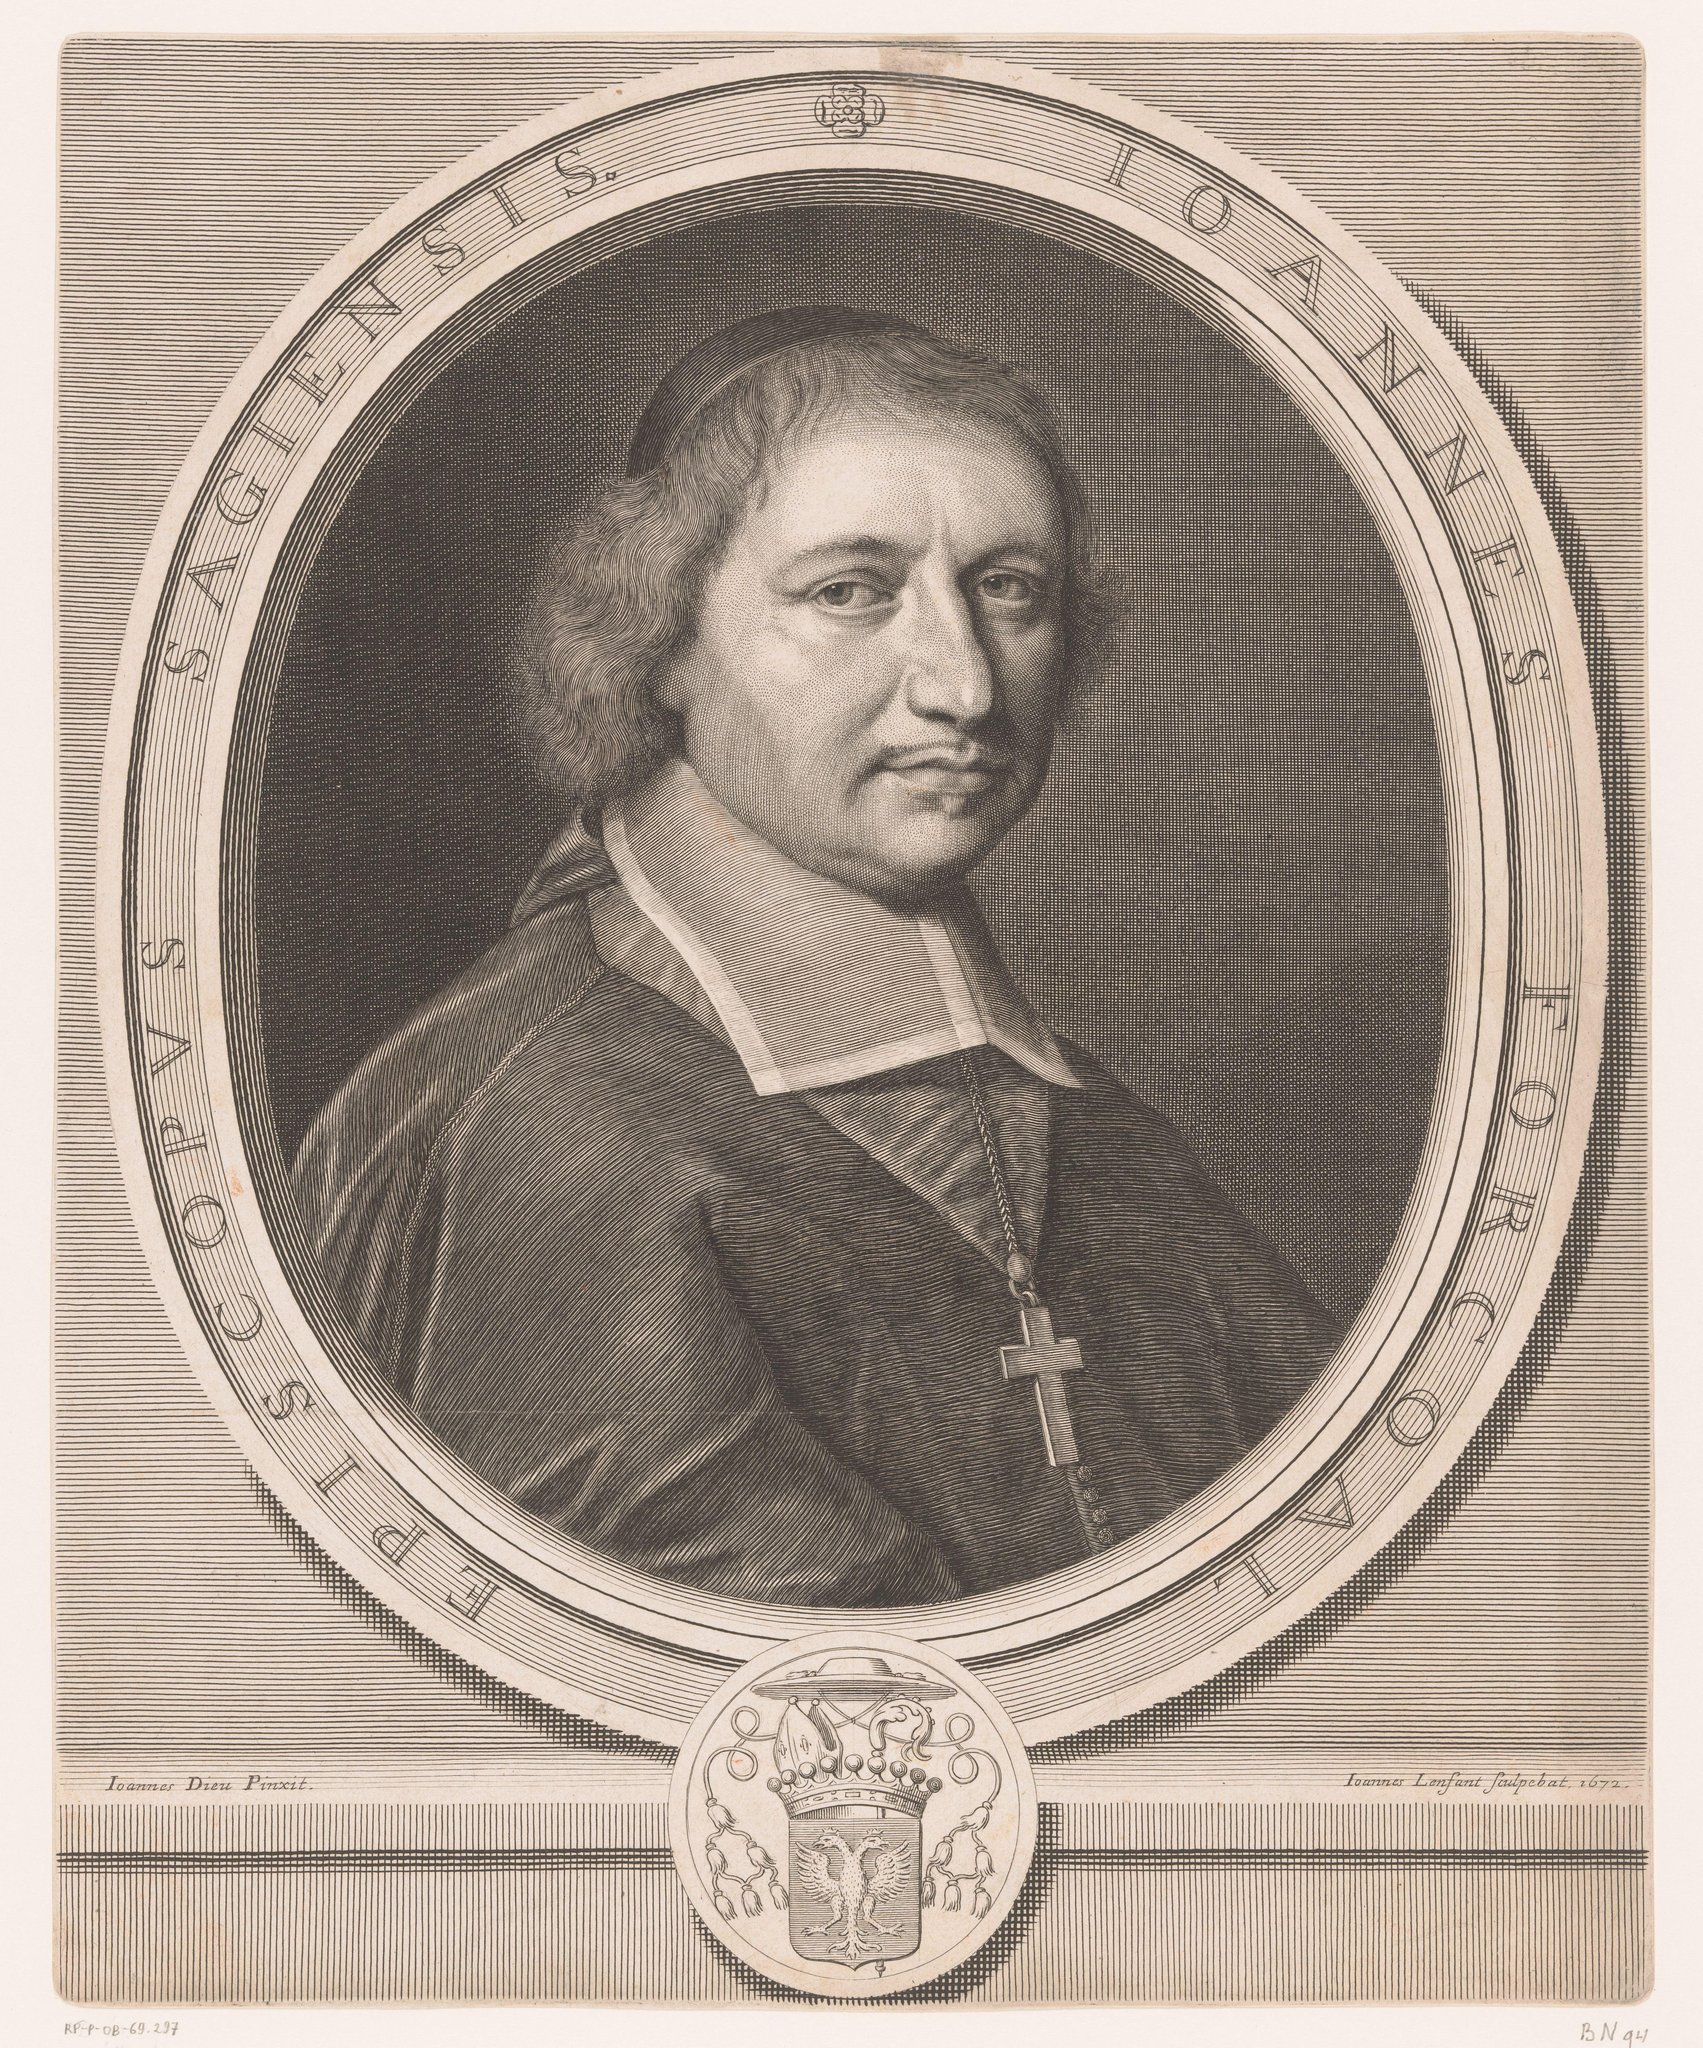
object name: print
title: Portret van Jean Forcoal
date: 1672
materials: paper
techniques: engraving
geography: france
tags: paris, archbishop, bishop, etc. (roman catholic), historical persons, armorial bearing, heraldry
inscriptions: collector's mark: Lugt 240